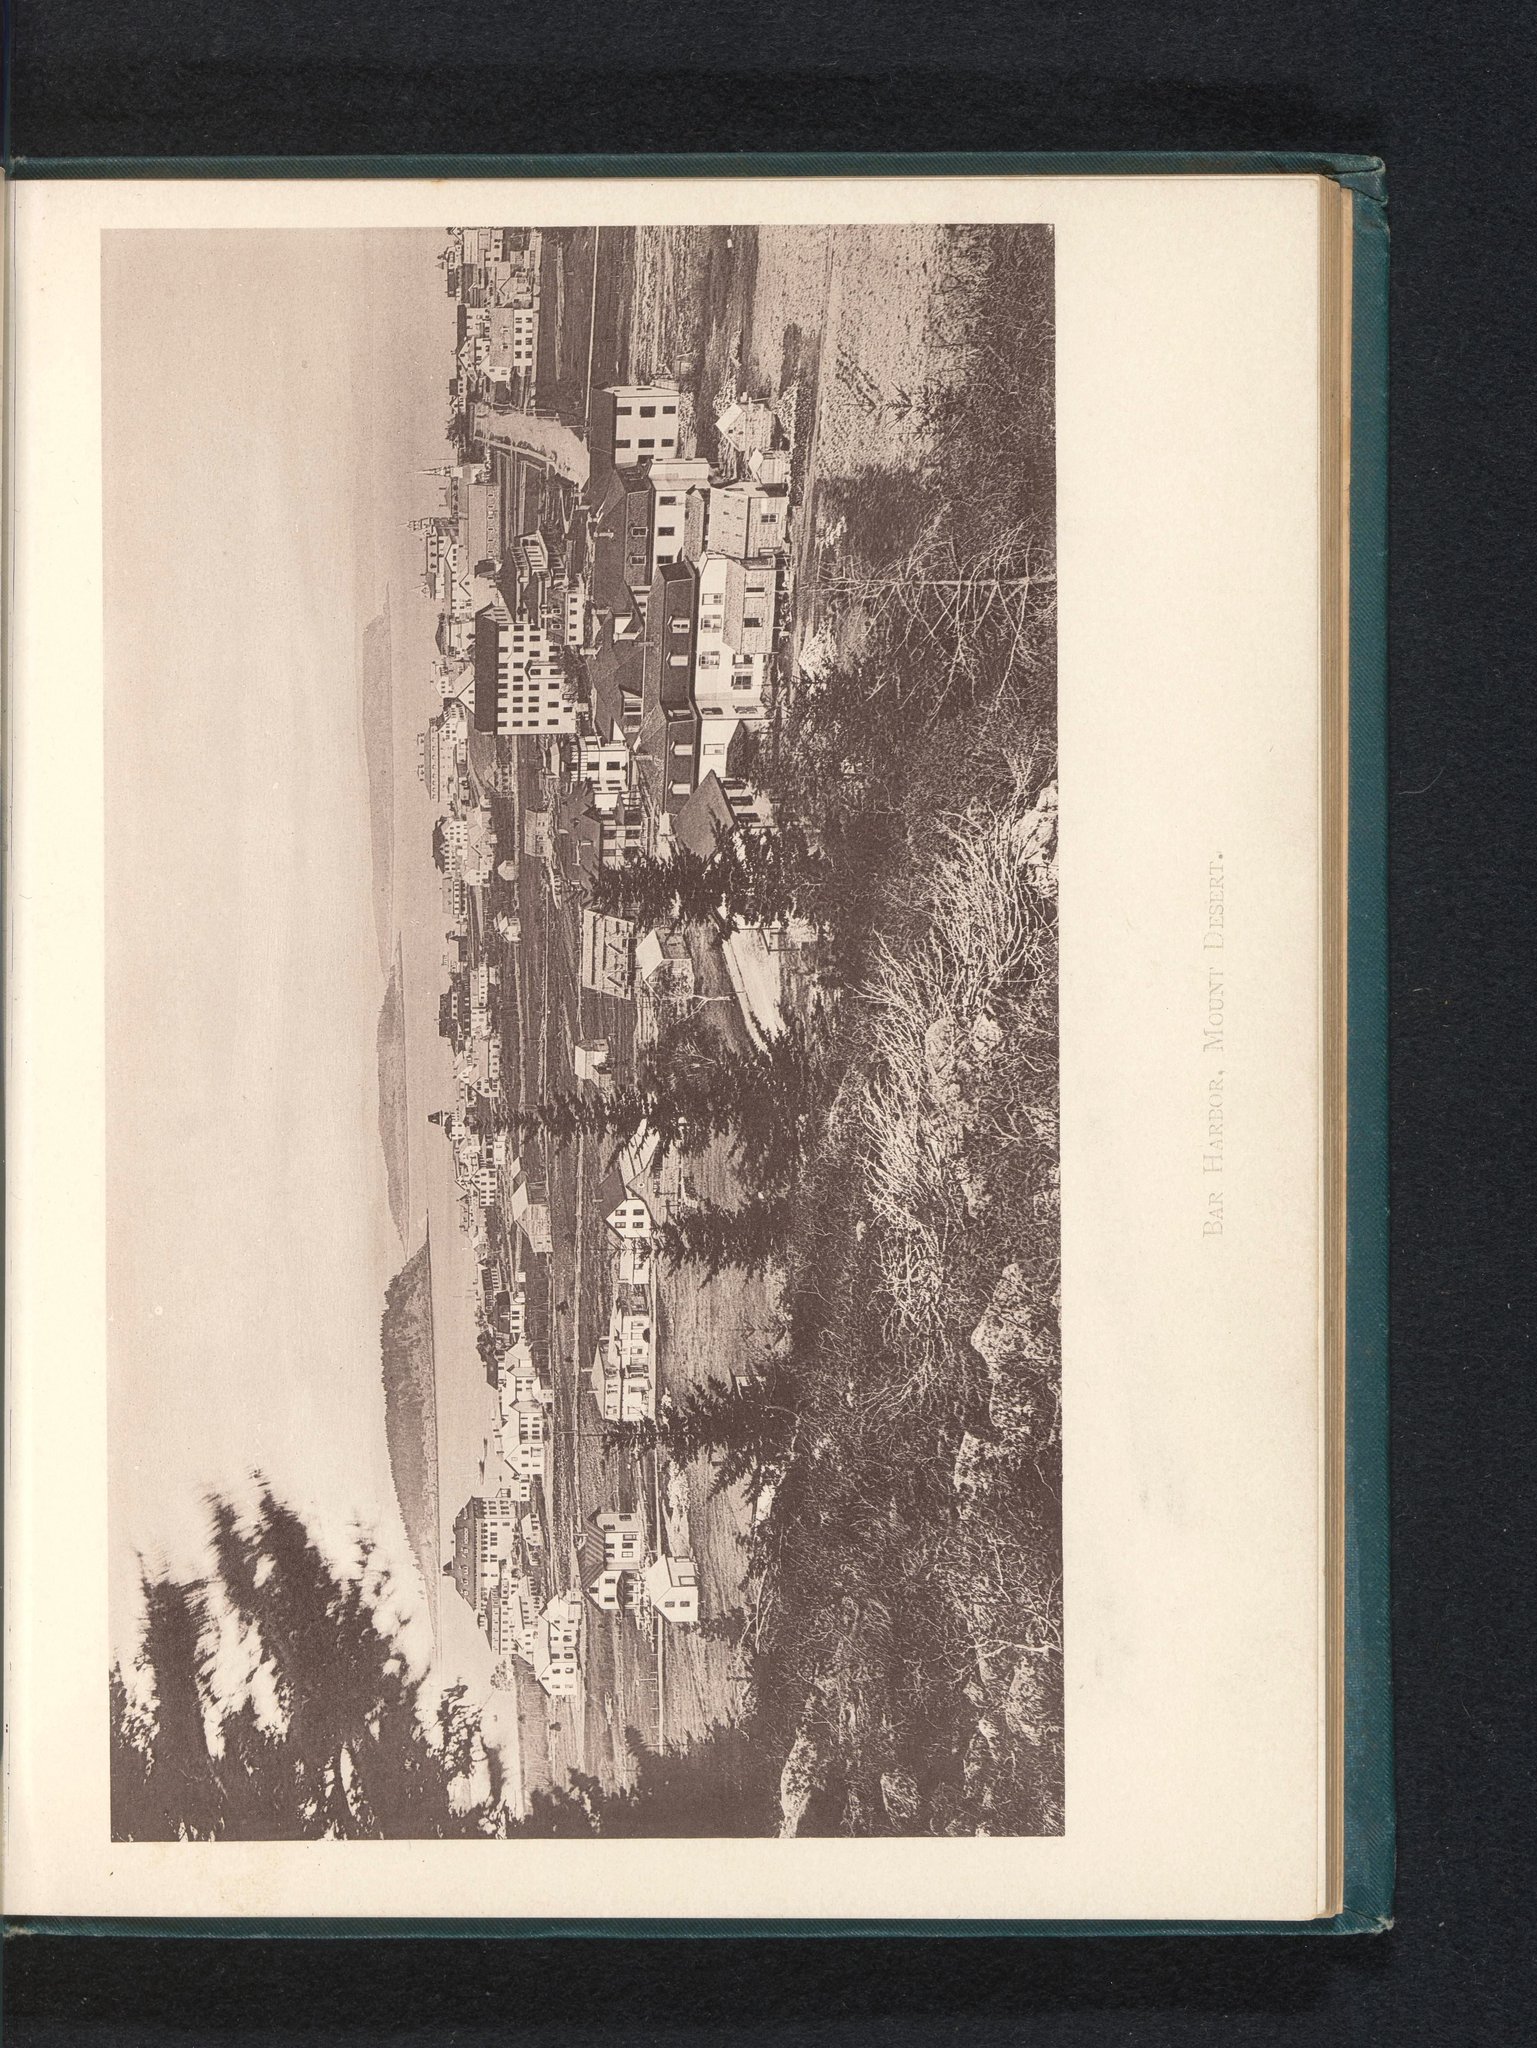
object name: photomechanical print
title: Bar Harbor, Mount Desert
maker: Anonymous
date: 1875-1880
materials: paper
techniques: photograph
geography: bar harbor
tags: city-view, and landscape with man-made constructions